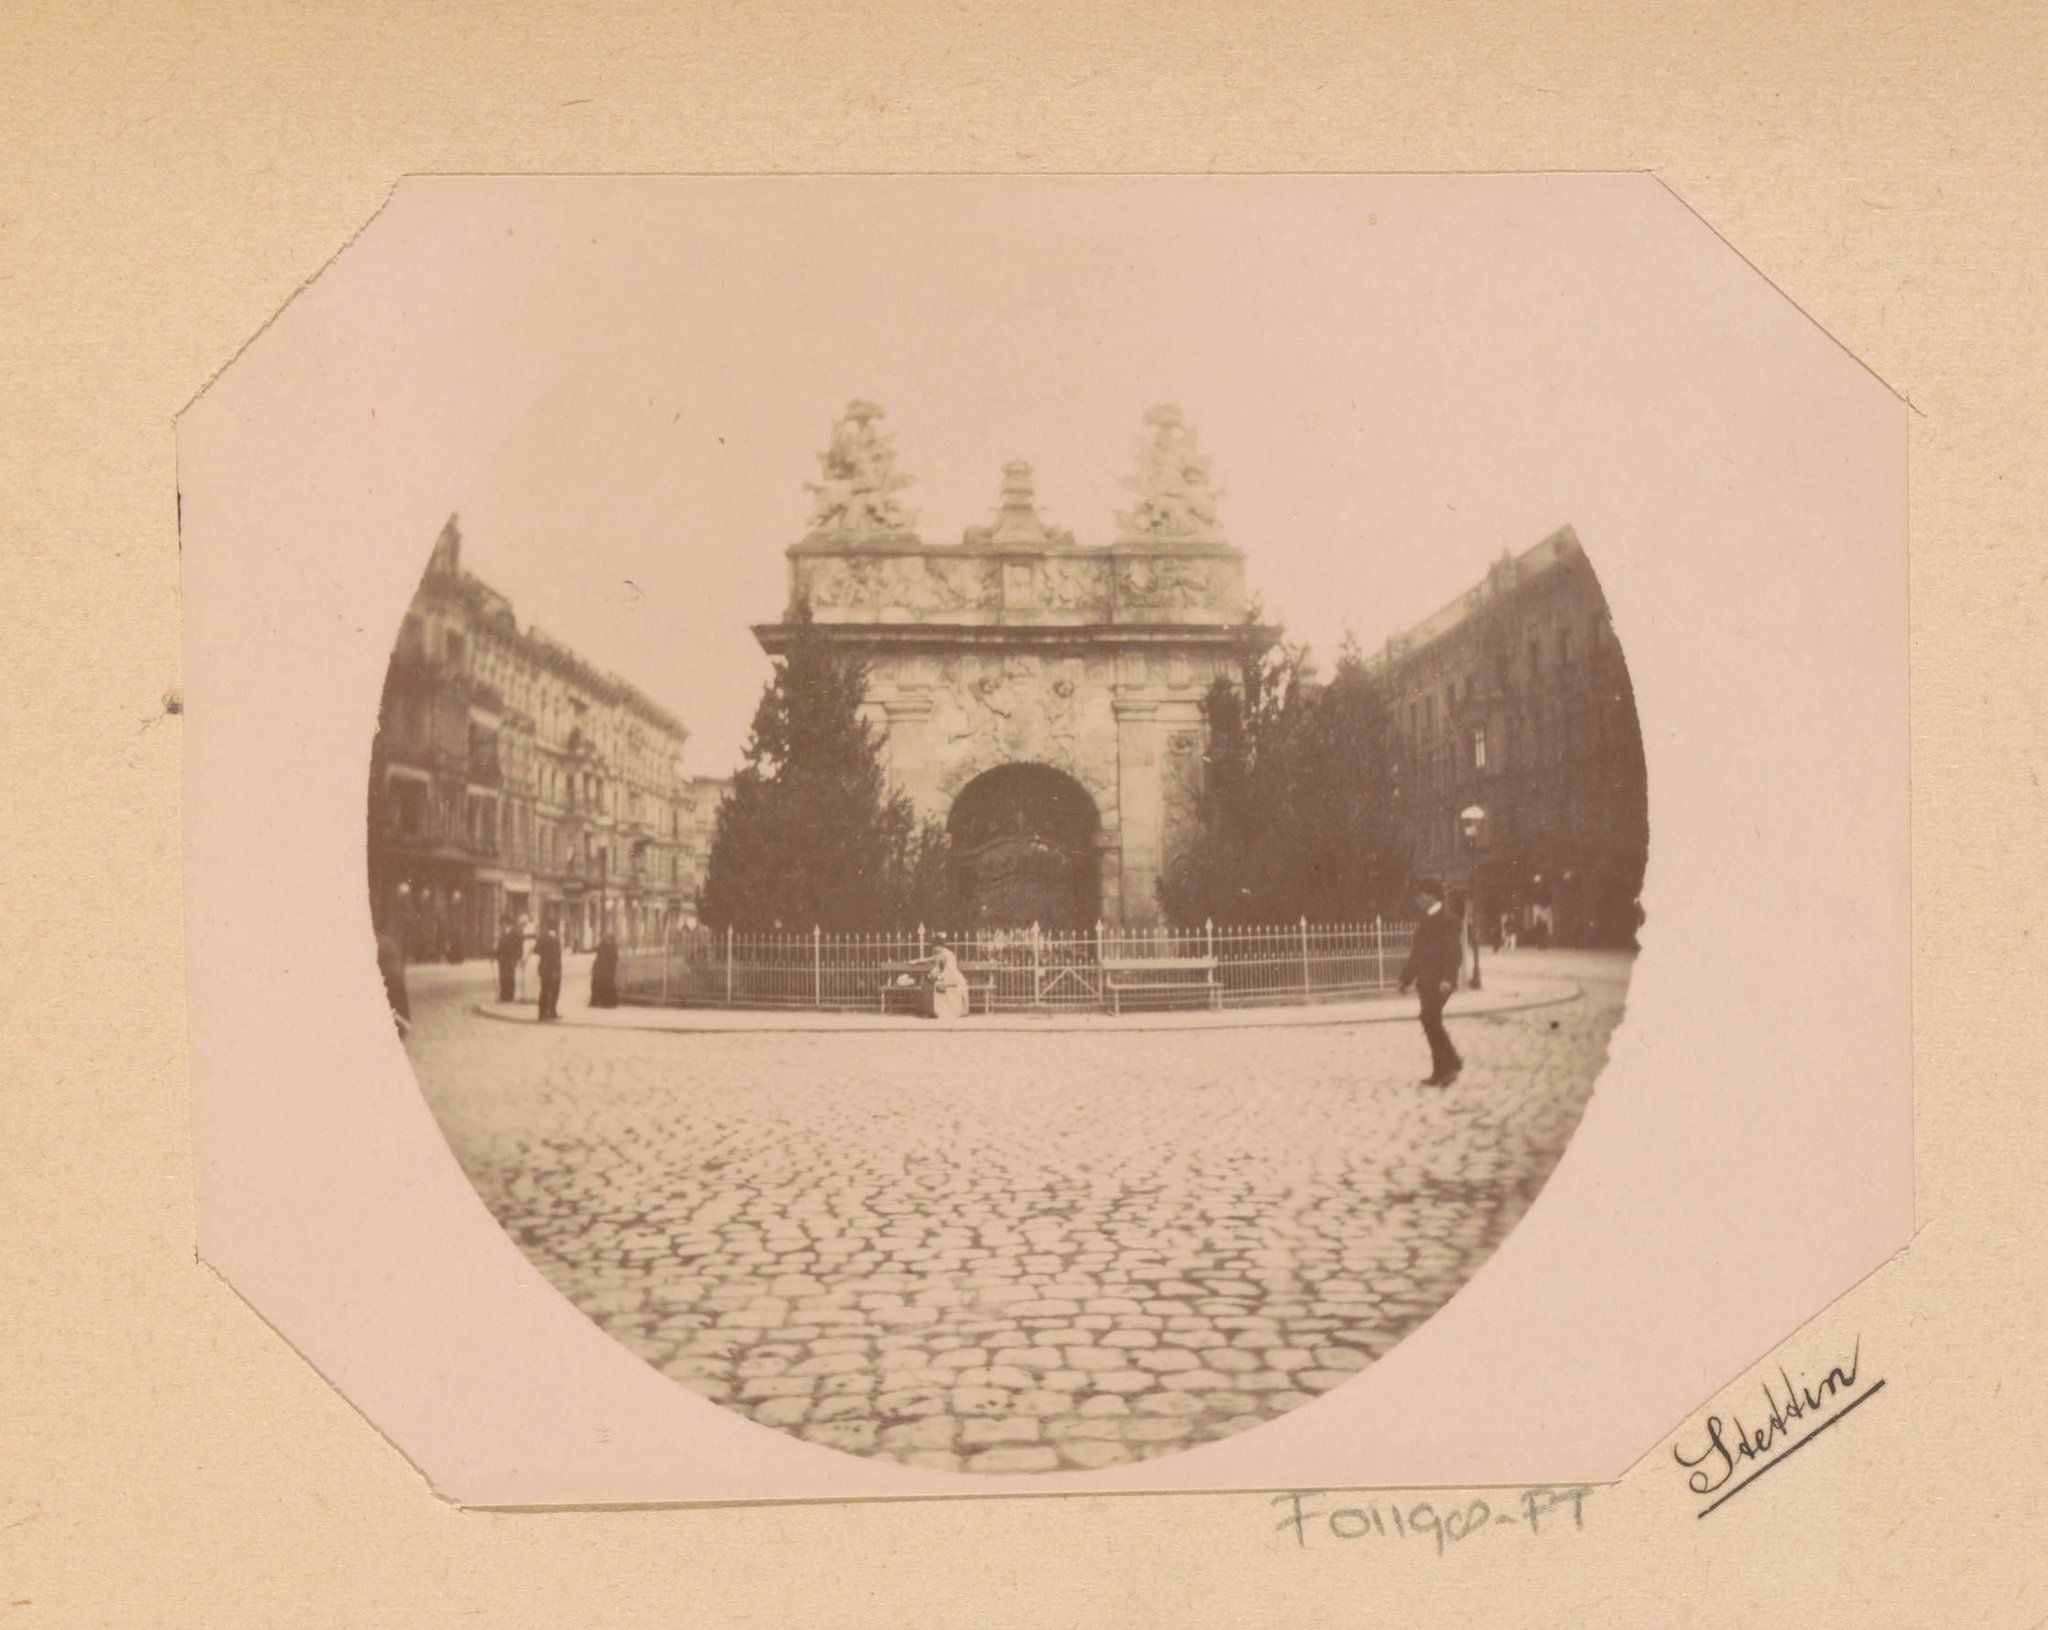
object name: album leaf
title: Stettin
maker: willem frederik piek jr.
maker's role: fotograaf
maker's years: 1874-1954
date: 1889-1893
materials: paper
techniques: gelatin silver print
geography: szczecin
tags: monument, statue